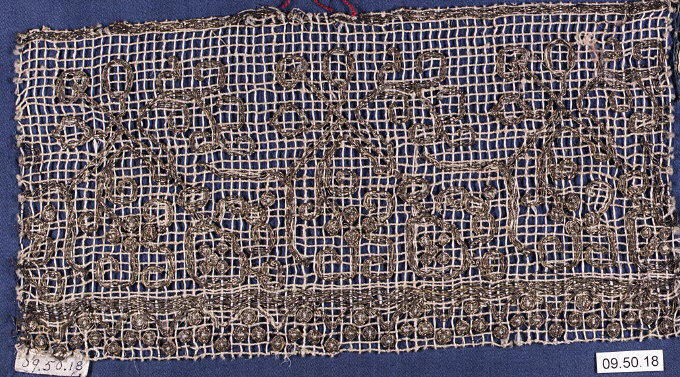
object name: fragment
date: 1501-1700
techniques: embroidery